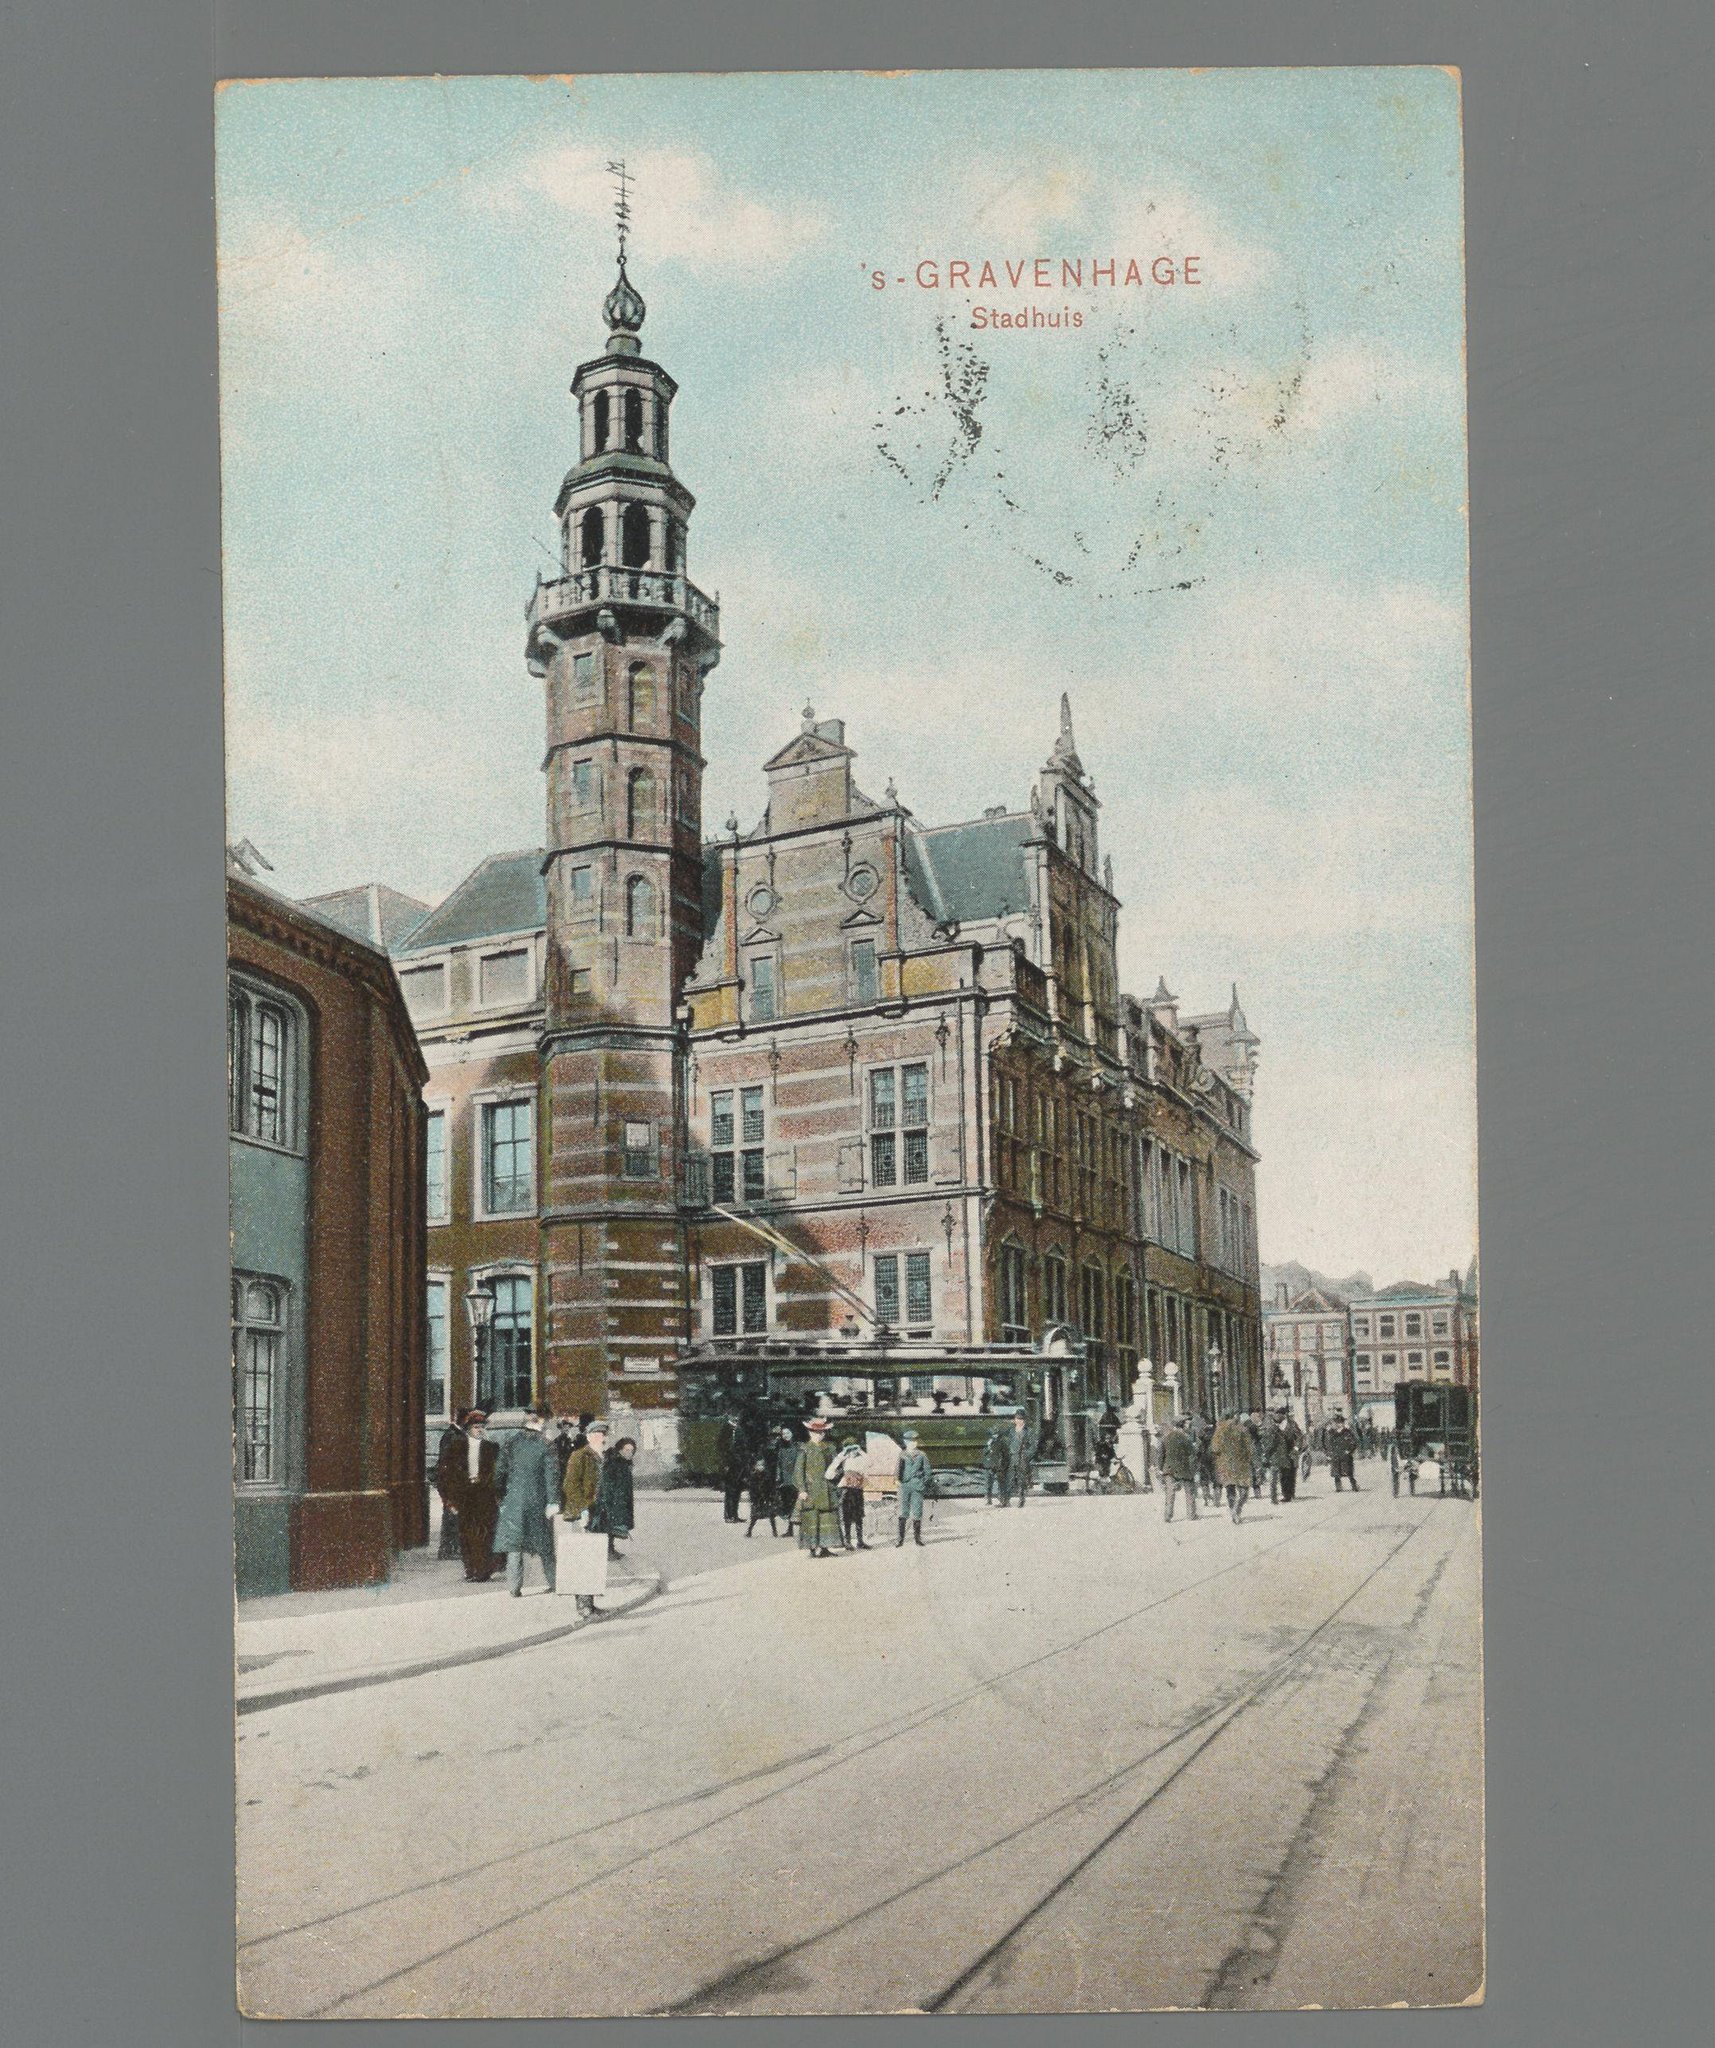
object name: photomechanical print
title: 's-Gravenhage. Stadhuis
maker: Anonymous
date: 1906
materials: cardboard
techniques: lithograph, writing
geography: the hague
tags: city-view, and landscape with man-made constructions, townhall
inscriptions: postage stamp